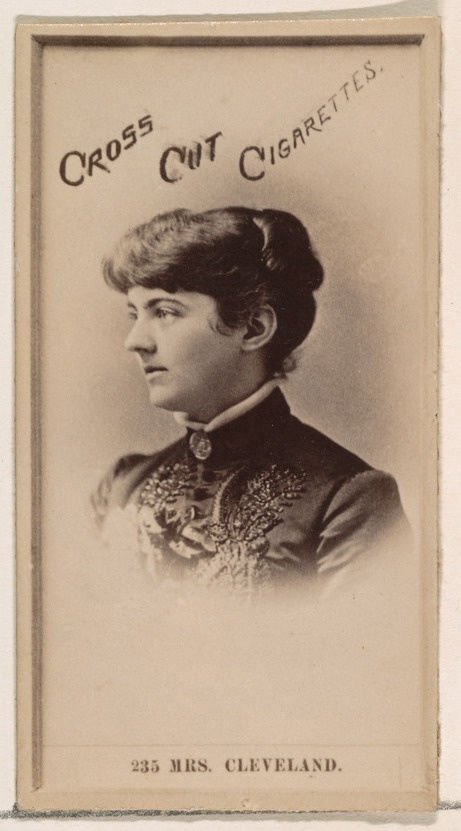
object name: print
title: Card Number 235, Mrs. Cleveland, from the Actors and Actresses series (N145-2) issued by Duke Sons & Co. to promote Cross Cut Cigarettes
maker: w. duke, sons & co.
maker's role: publisher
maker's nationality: american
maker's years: 1870-1920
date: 1880-1889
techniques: albumen silver print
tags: women,actresses